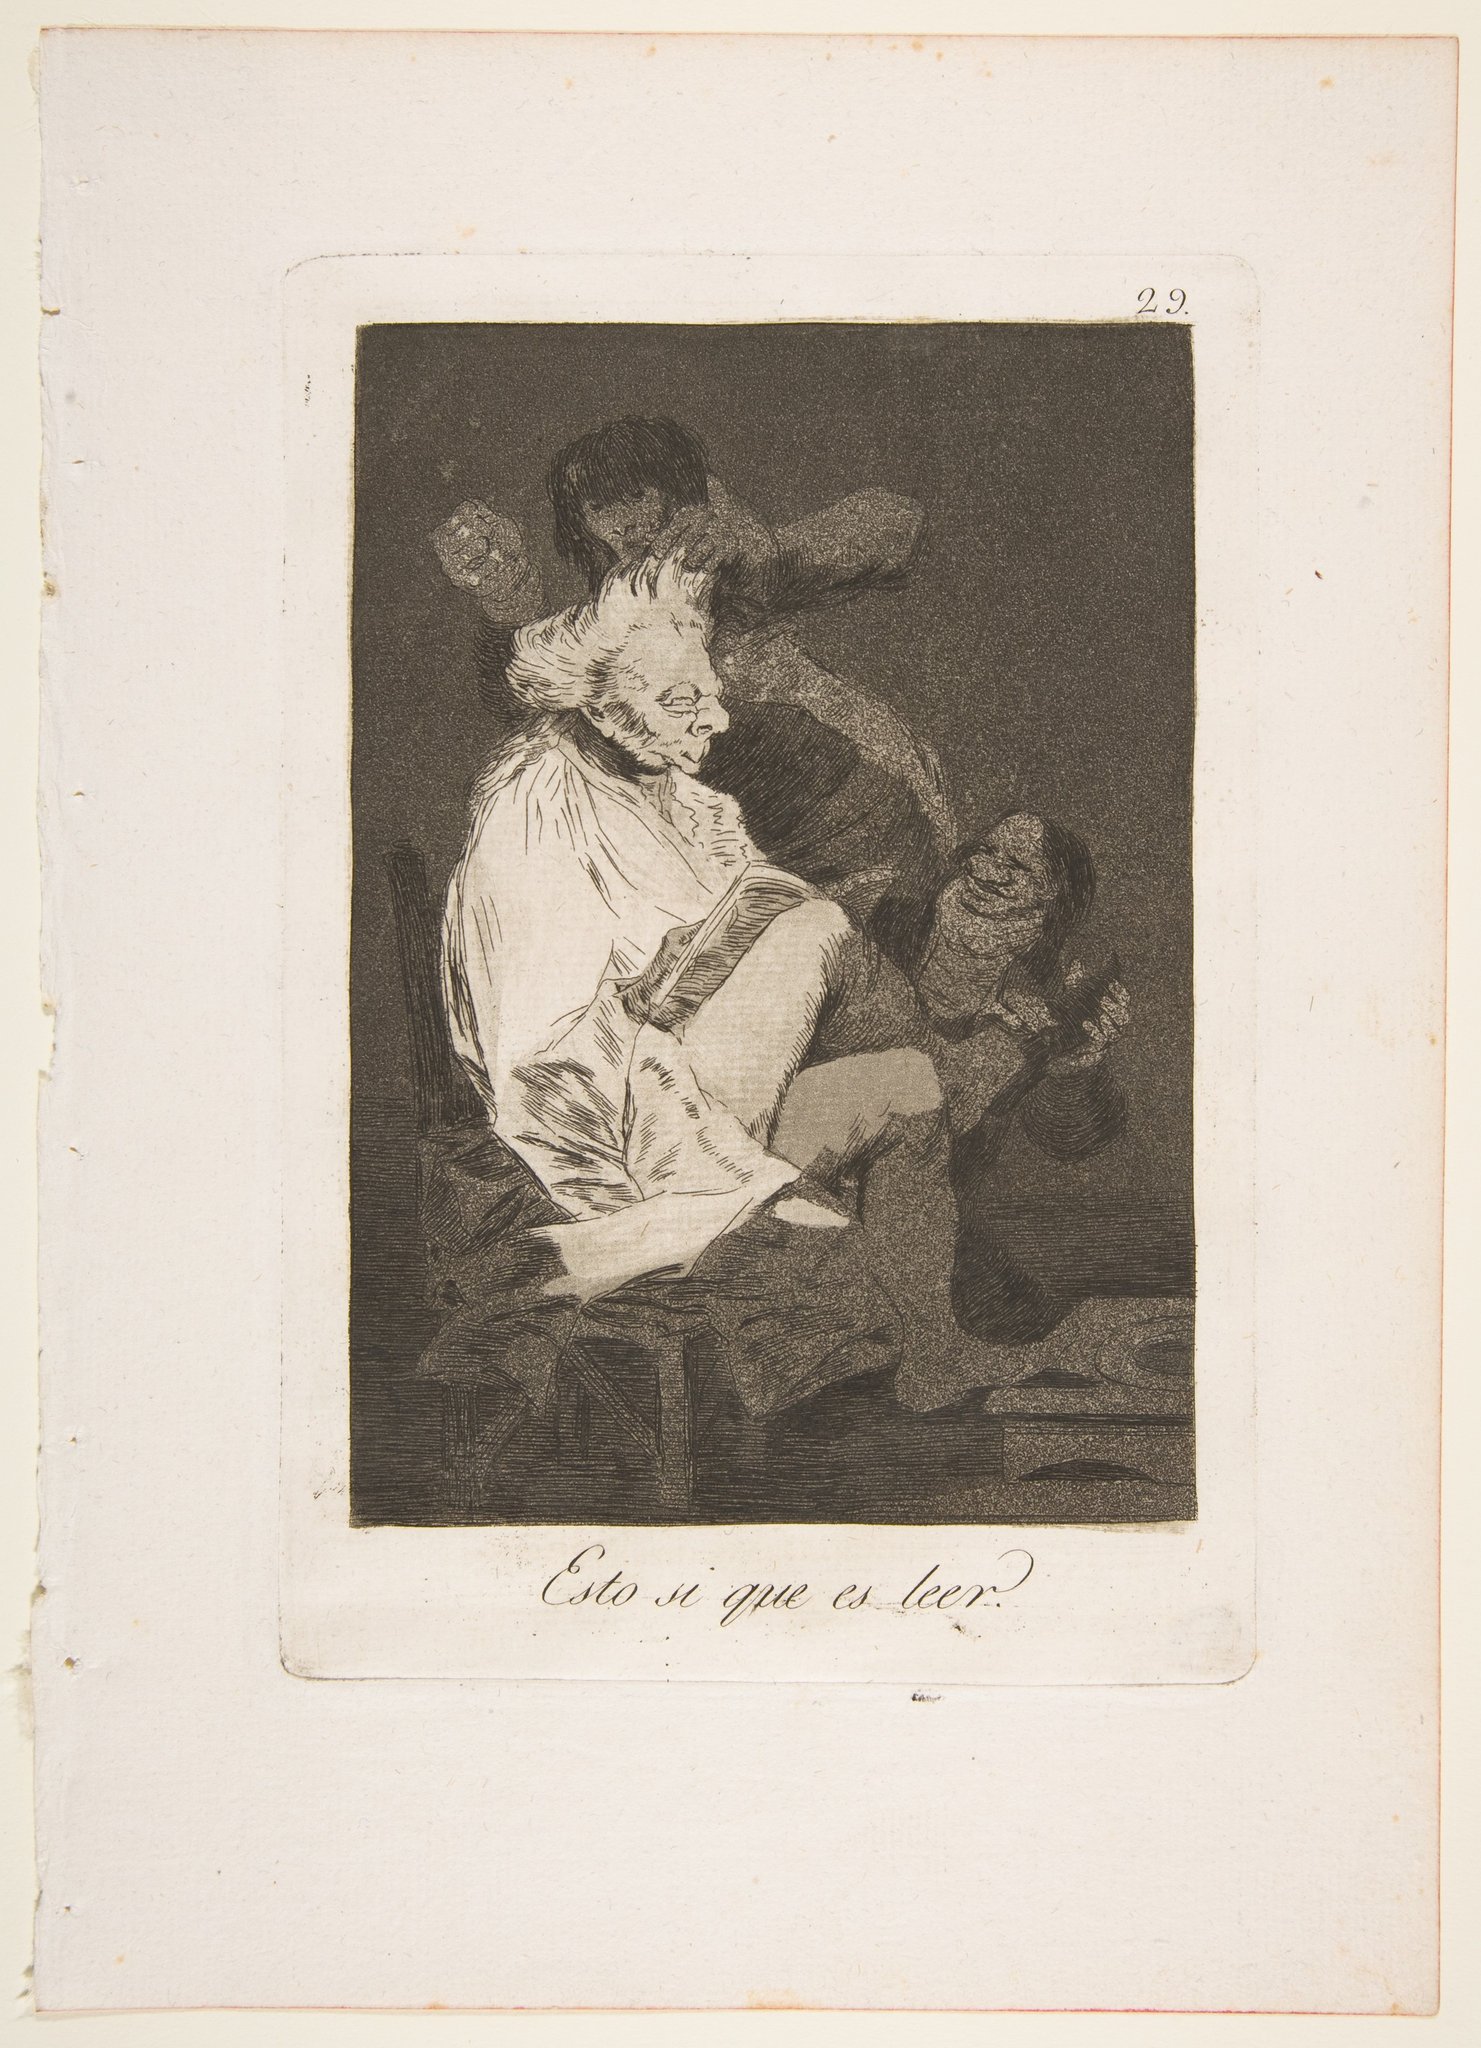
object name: print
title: Plate 29 from "Los Caprichos": That certainly is being able to read (Esto si que es leer)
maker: goya (francisco de goya y lucientes)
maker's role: artist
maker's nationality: spanish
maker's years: 1746-1828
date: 1799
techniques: aquatint, burnishing, drypoint, etching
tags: men,reading